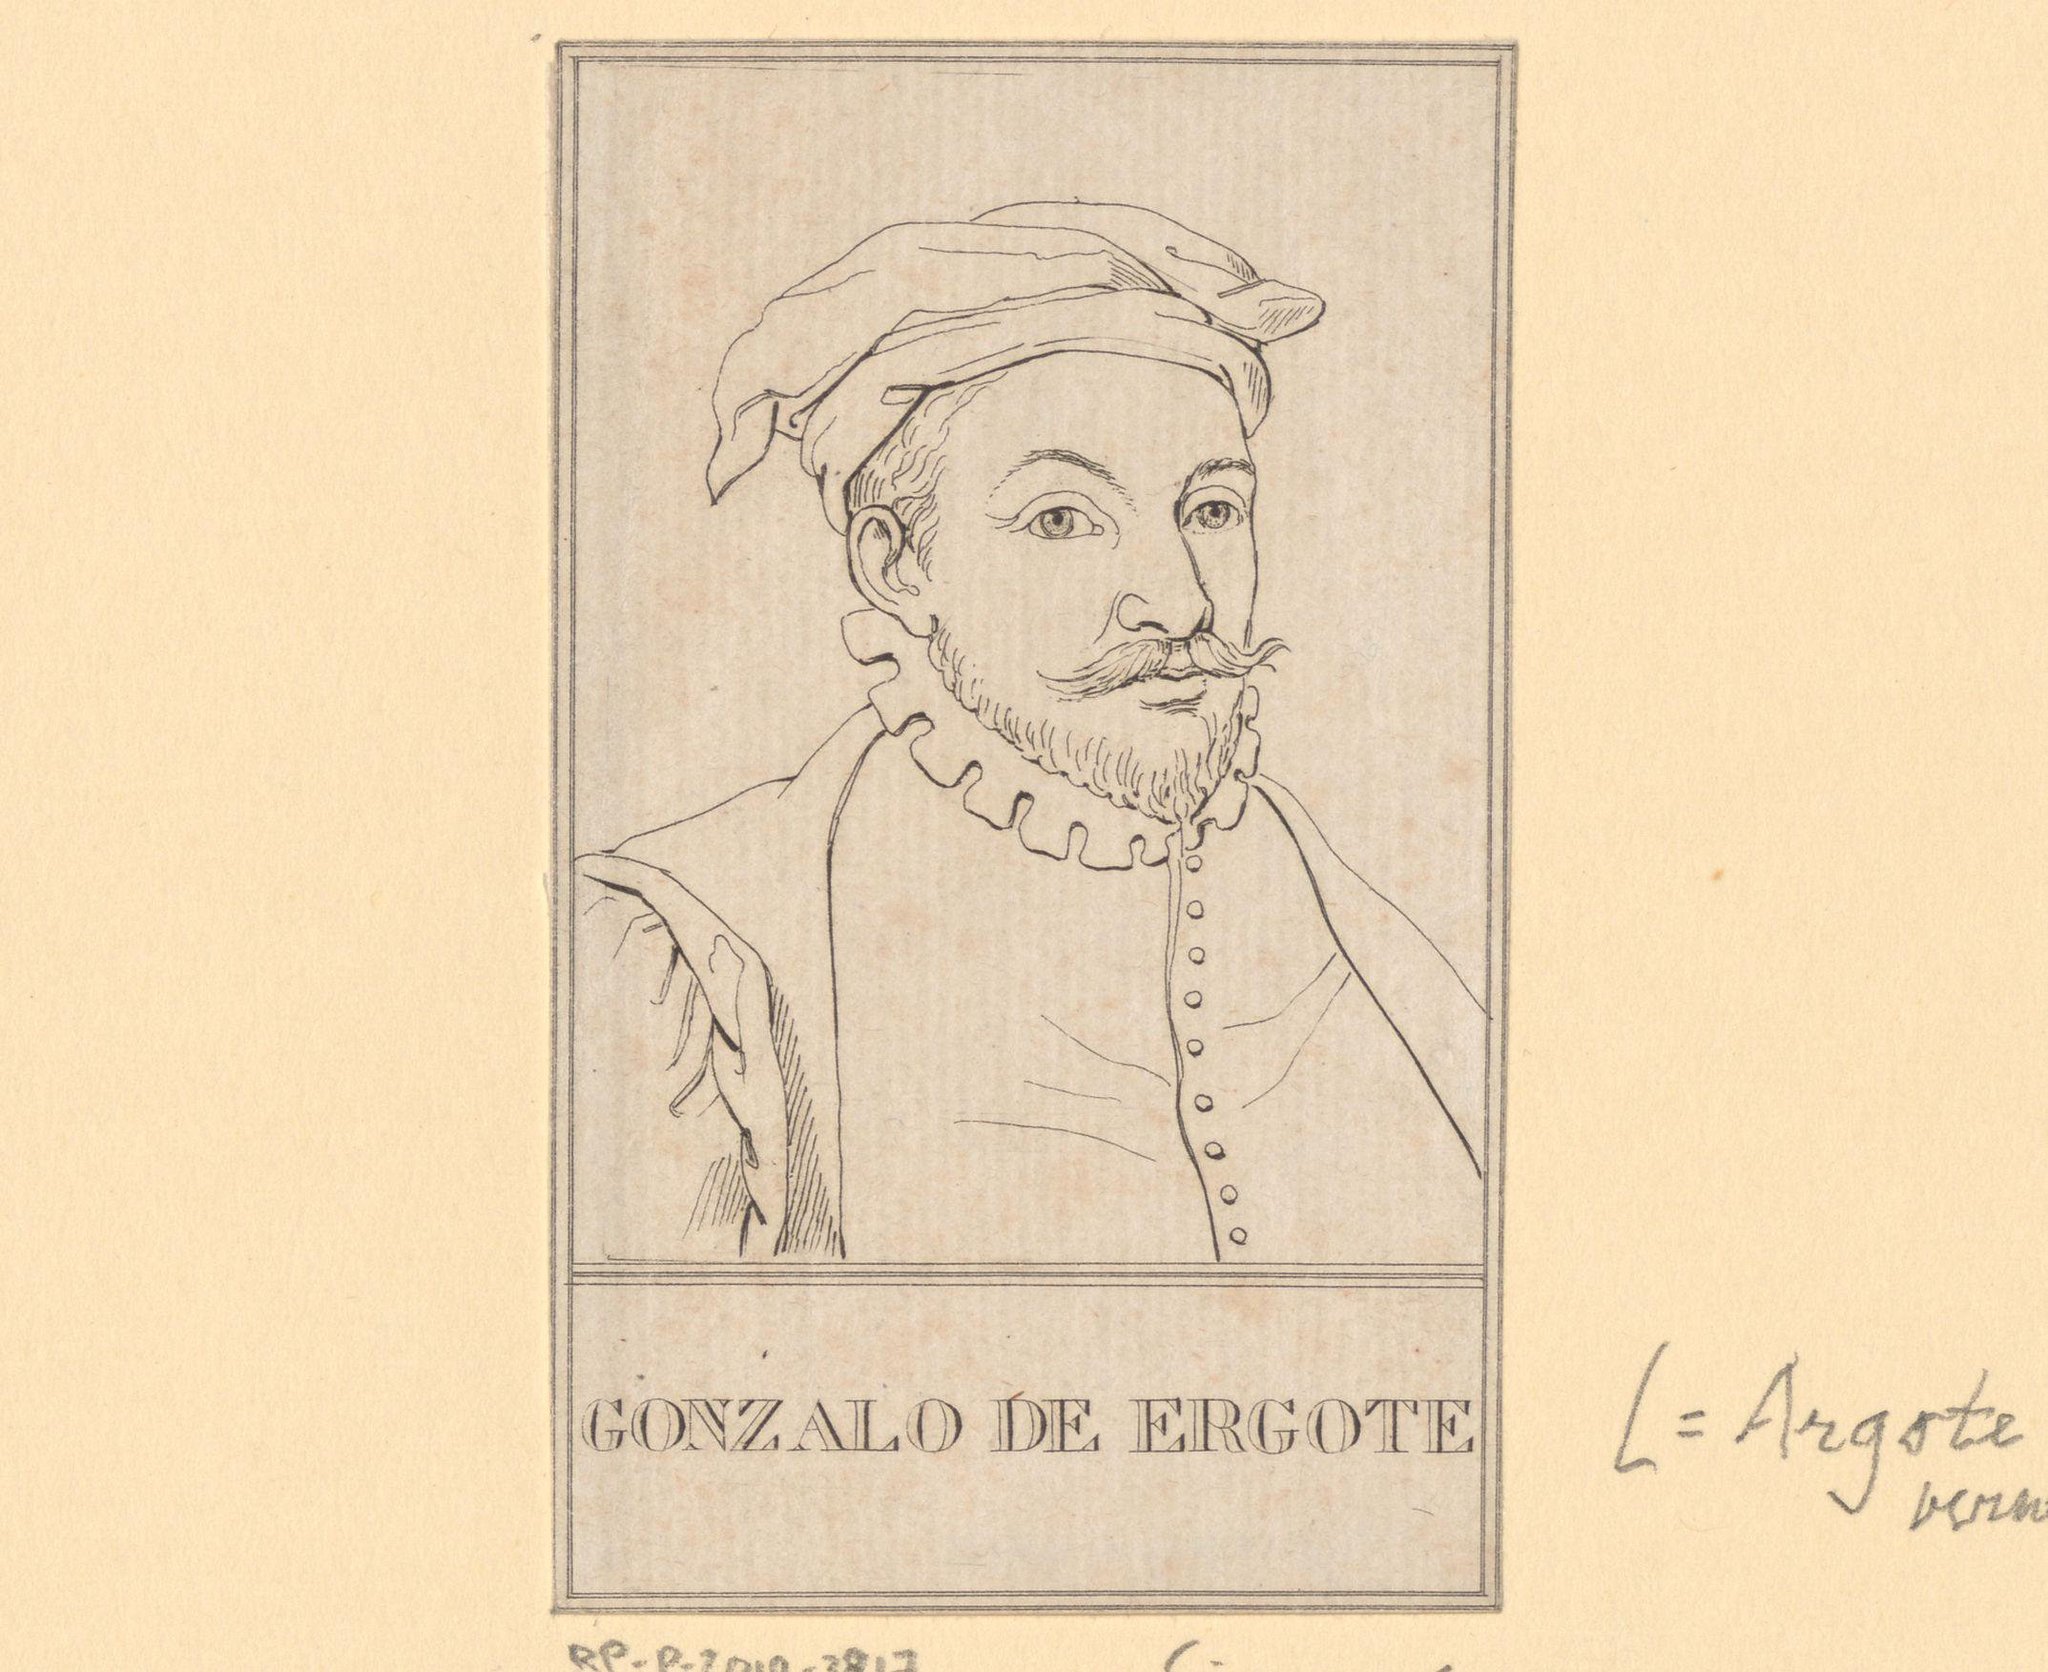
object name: book illustration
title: Portret van Gonzalo Argote de Molina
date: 1811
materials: paper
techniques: etching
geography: paris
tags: historical persons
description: Prent uit: Galerie historique des hommes les plus celebres de tous les siecles et de toutes les nations. Parijs: Charles Paul Landon, 1811, dl. 9.